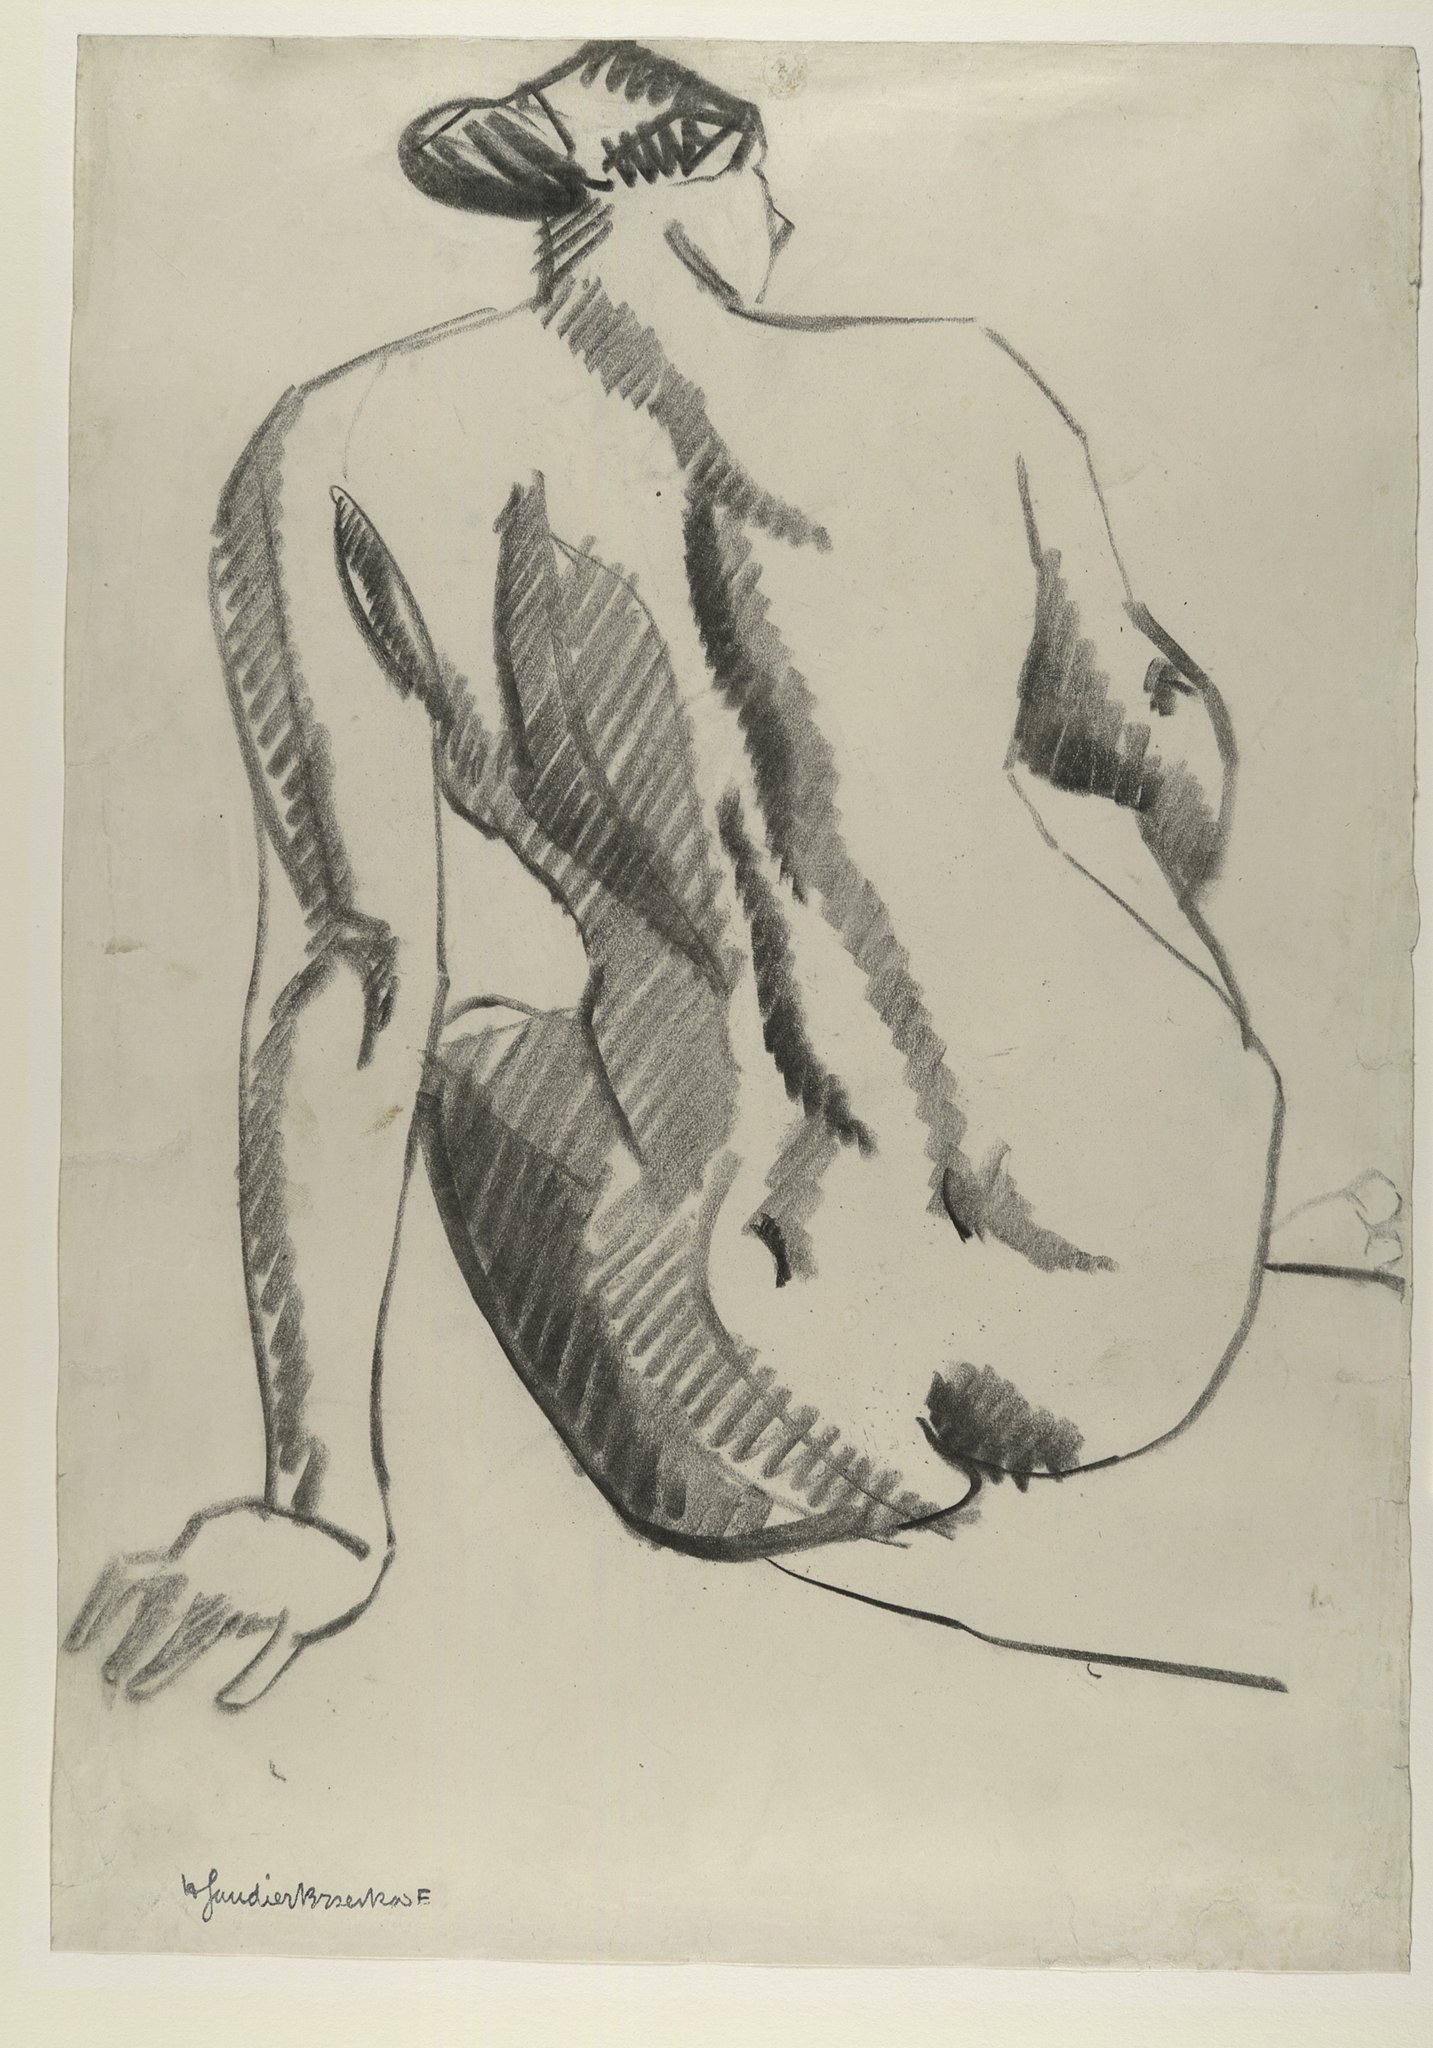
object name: drawing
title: Seated Nude, Back-View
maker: henri gaudier-brzeska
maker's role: artist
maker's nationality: french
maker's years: 1891-1915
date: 1913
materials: charcoal, paper